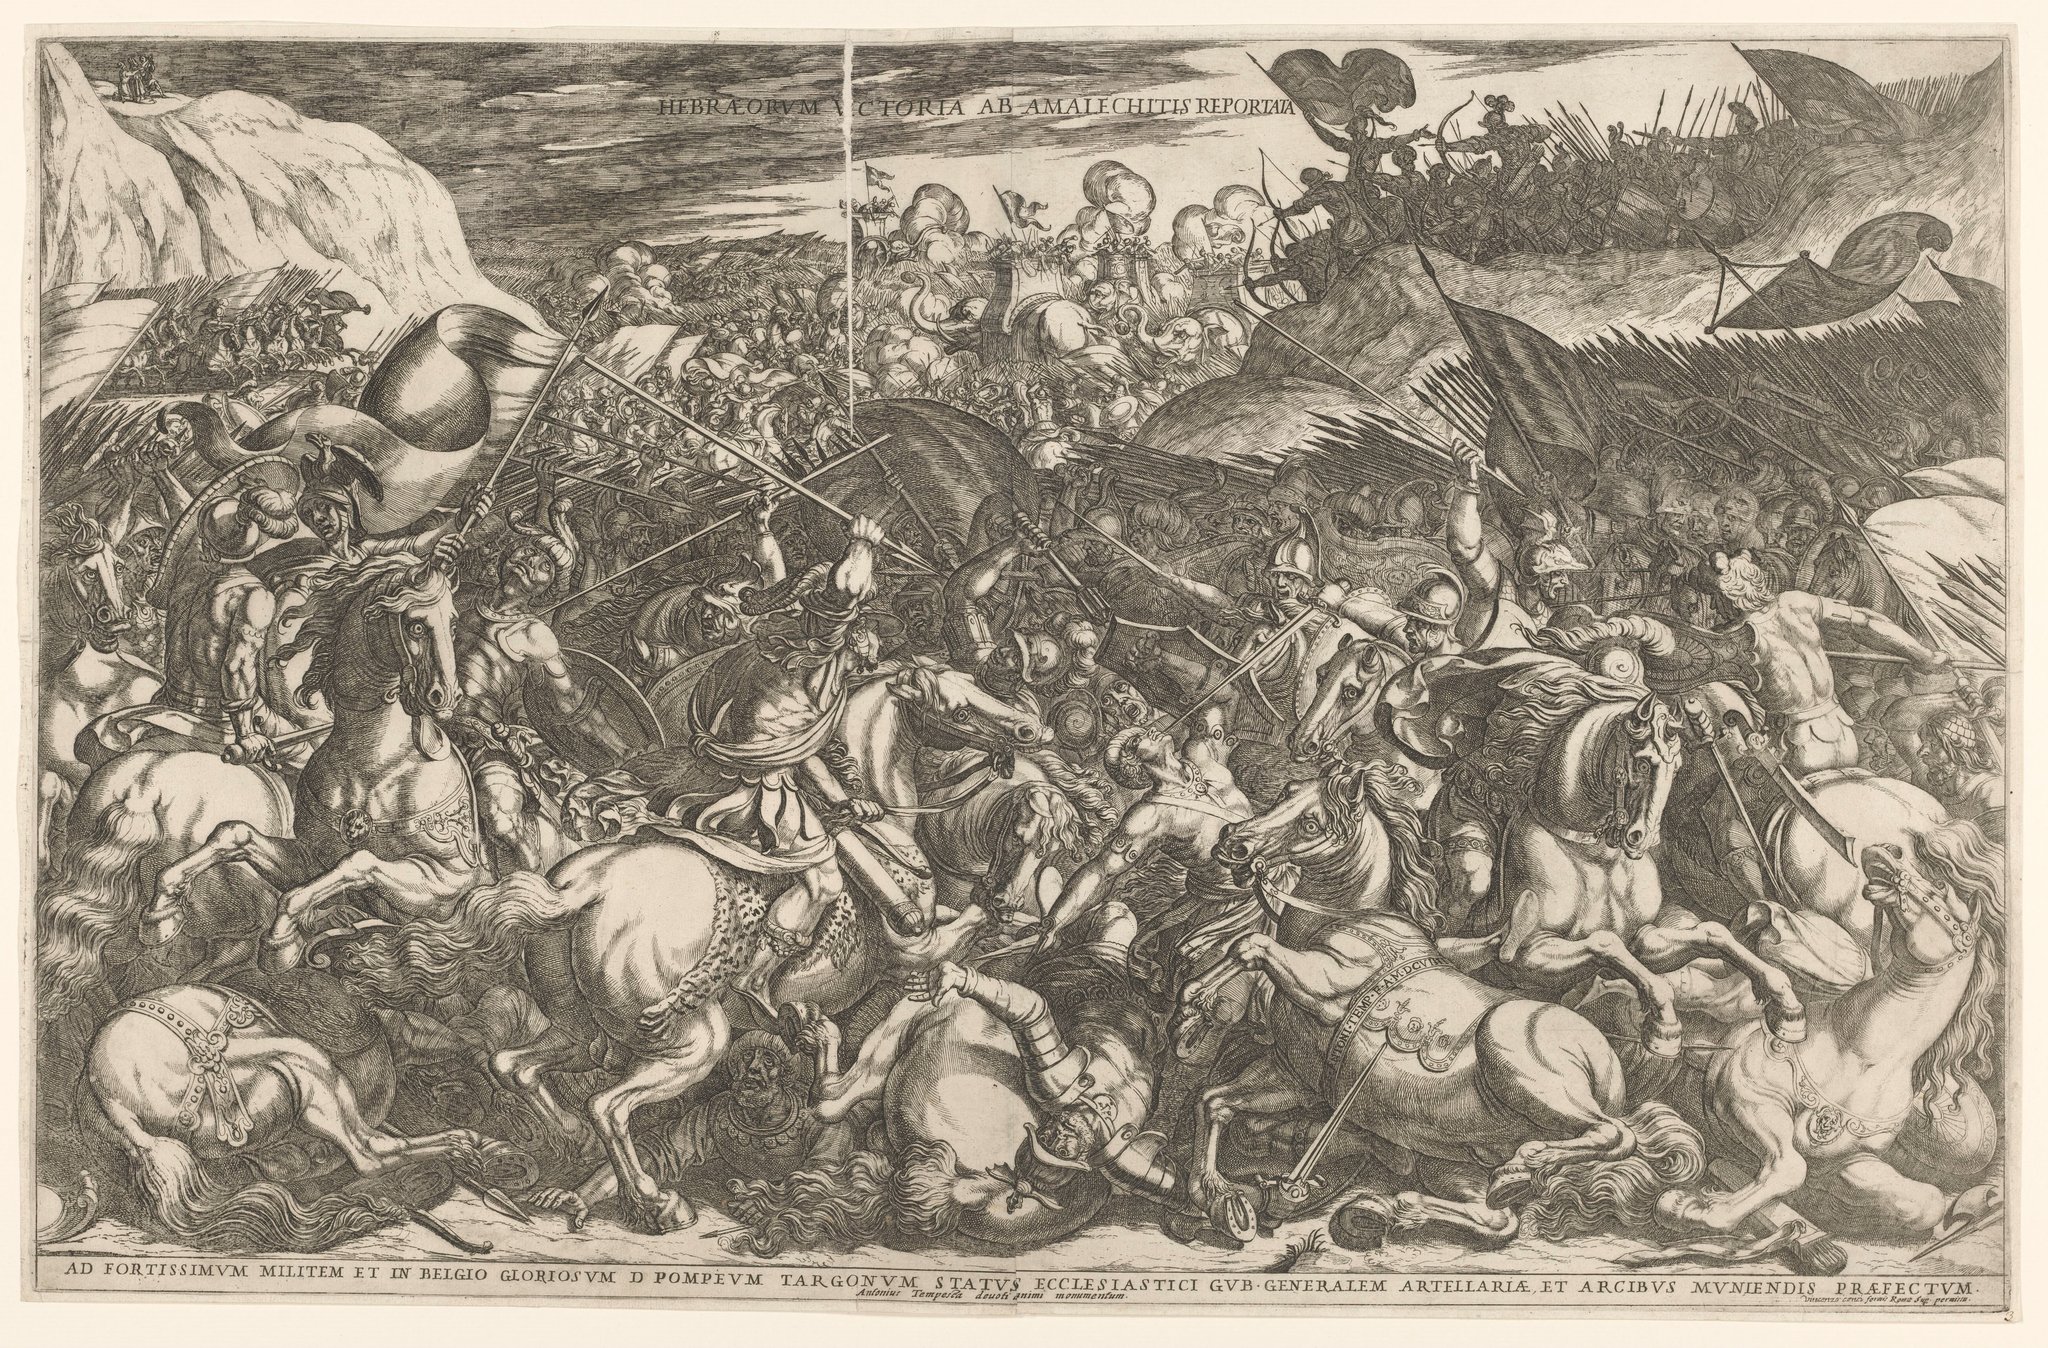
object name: print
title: Strijd tussen de Israëlieten en de Amalekieten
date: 1650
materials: paper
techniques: engraving, etching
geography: italy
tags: battle, warfare; military affairs (+ cavalry, horsemen), the soldier; the soldier's life, fighting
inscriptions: collector's mark: Lugt 11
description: De strijd tussen de Israëlieten en de Amalekieten. Een strijdgewoel van soldaten te paard en met speren. Opdracht in ondermarge in het Latijn.